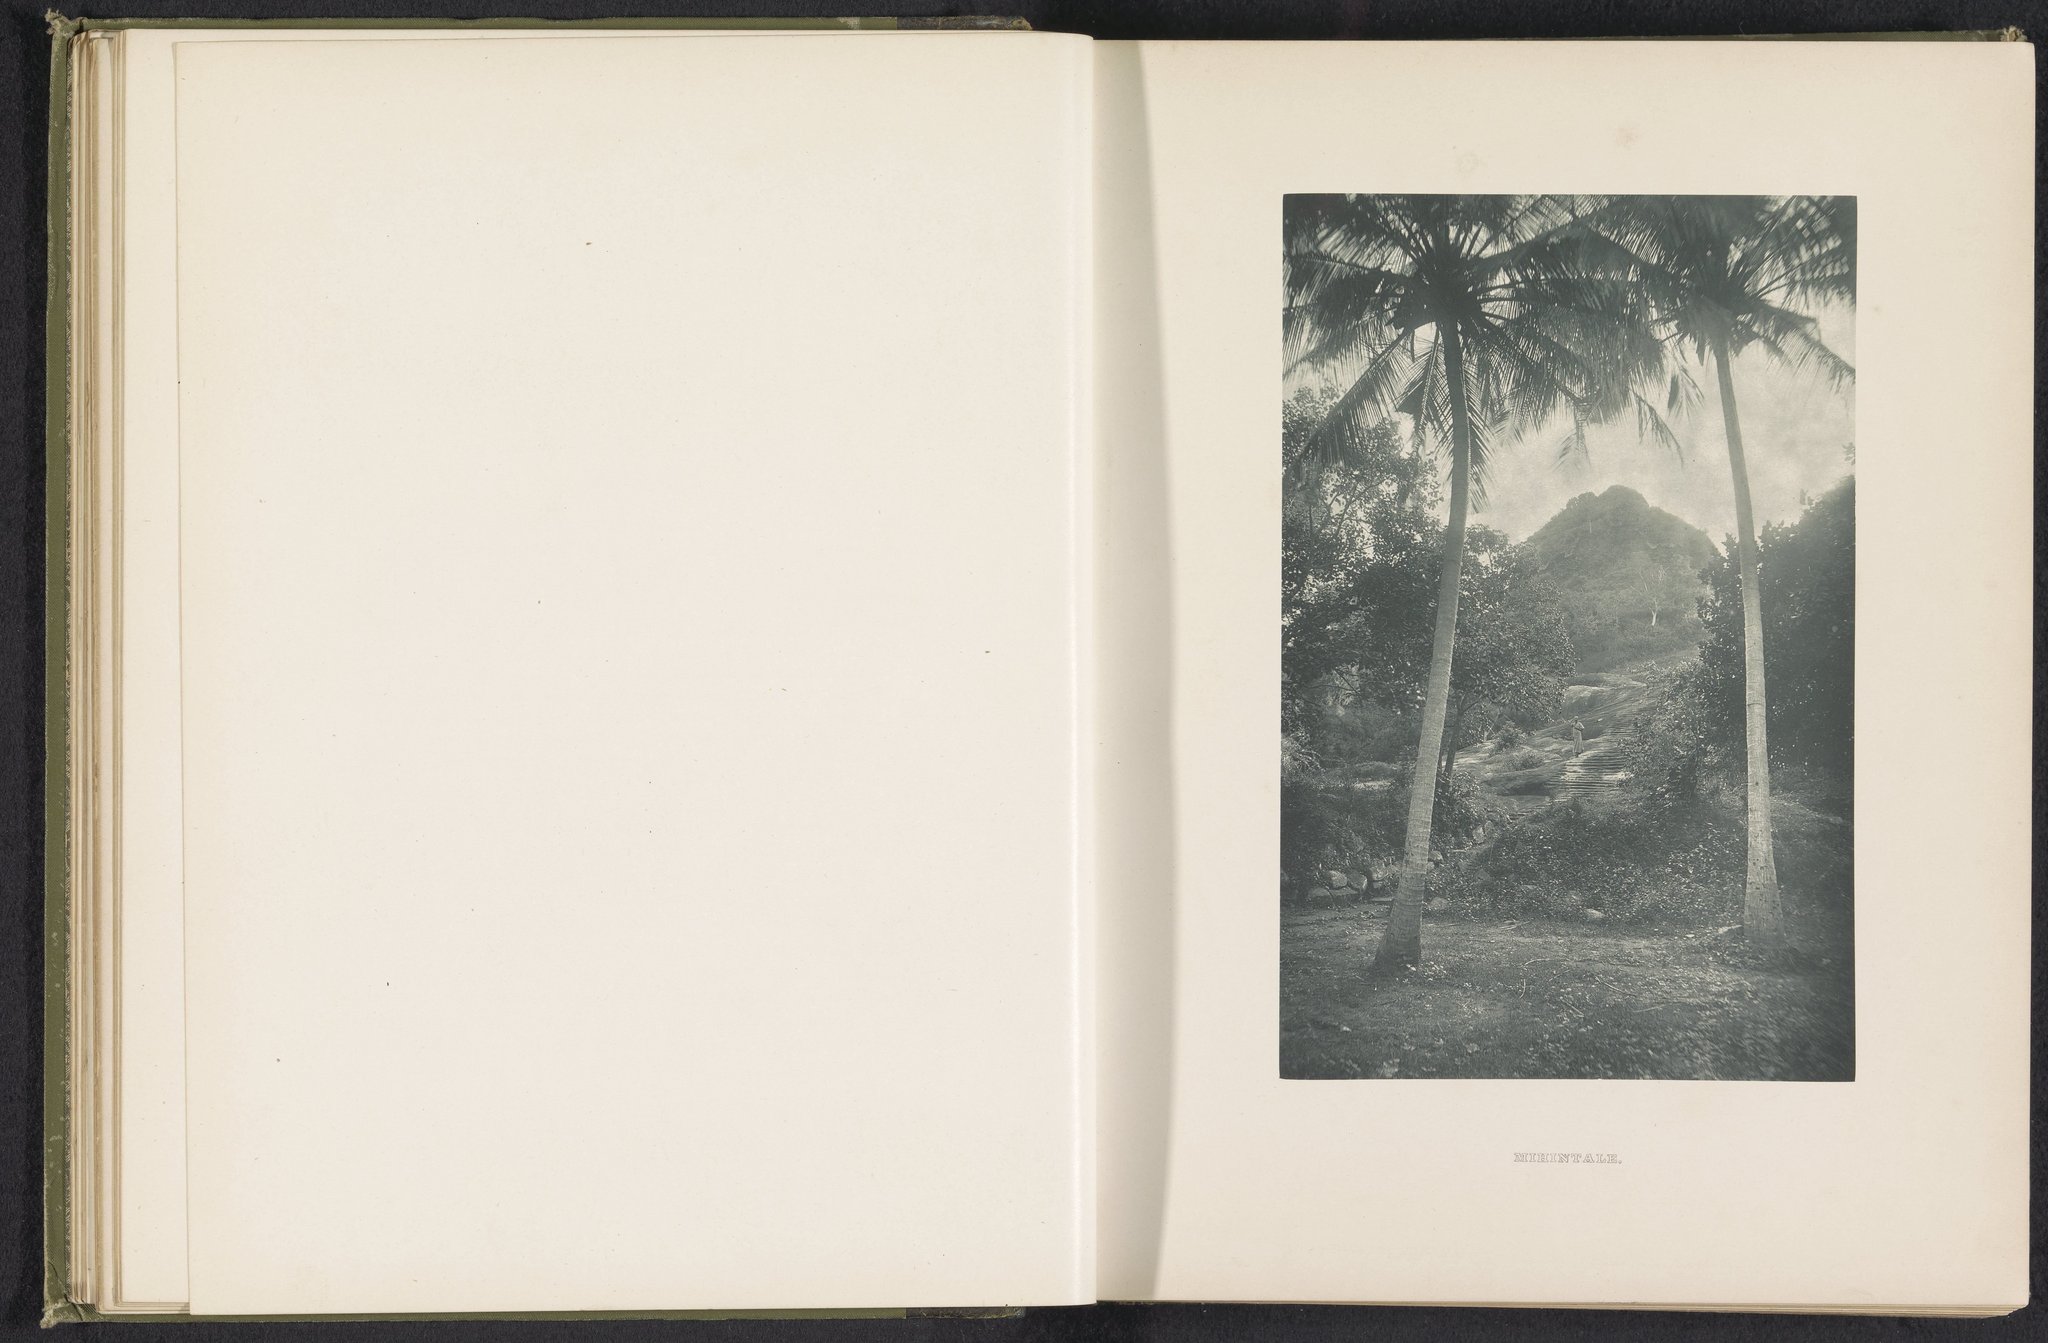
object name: page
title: View of Mihintale, Sri Lanka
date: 1896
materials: paper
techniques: woodburygravure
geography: sri lanka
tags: flight of steps, mountains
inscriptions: title: ‘MIHINTALE.’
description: Mihintale is de plek dat het Boeddhisme in Sri Lanka werd geïntroduceerd.